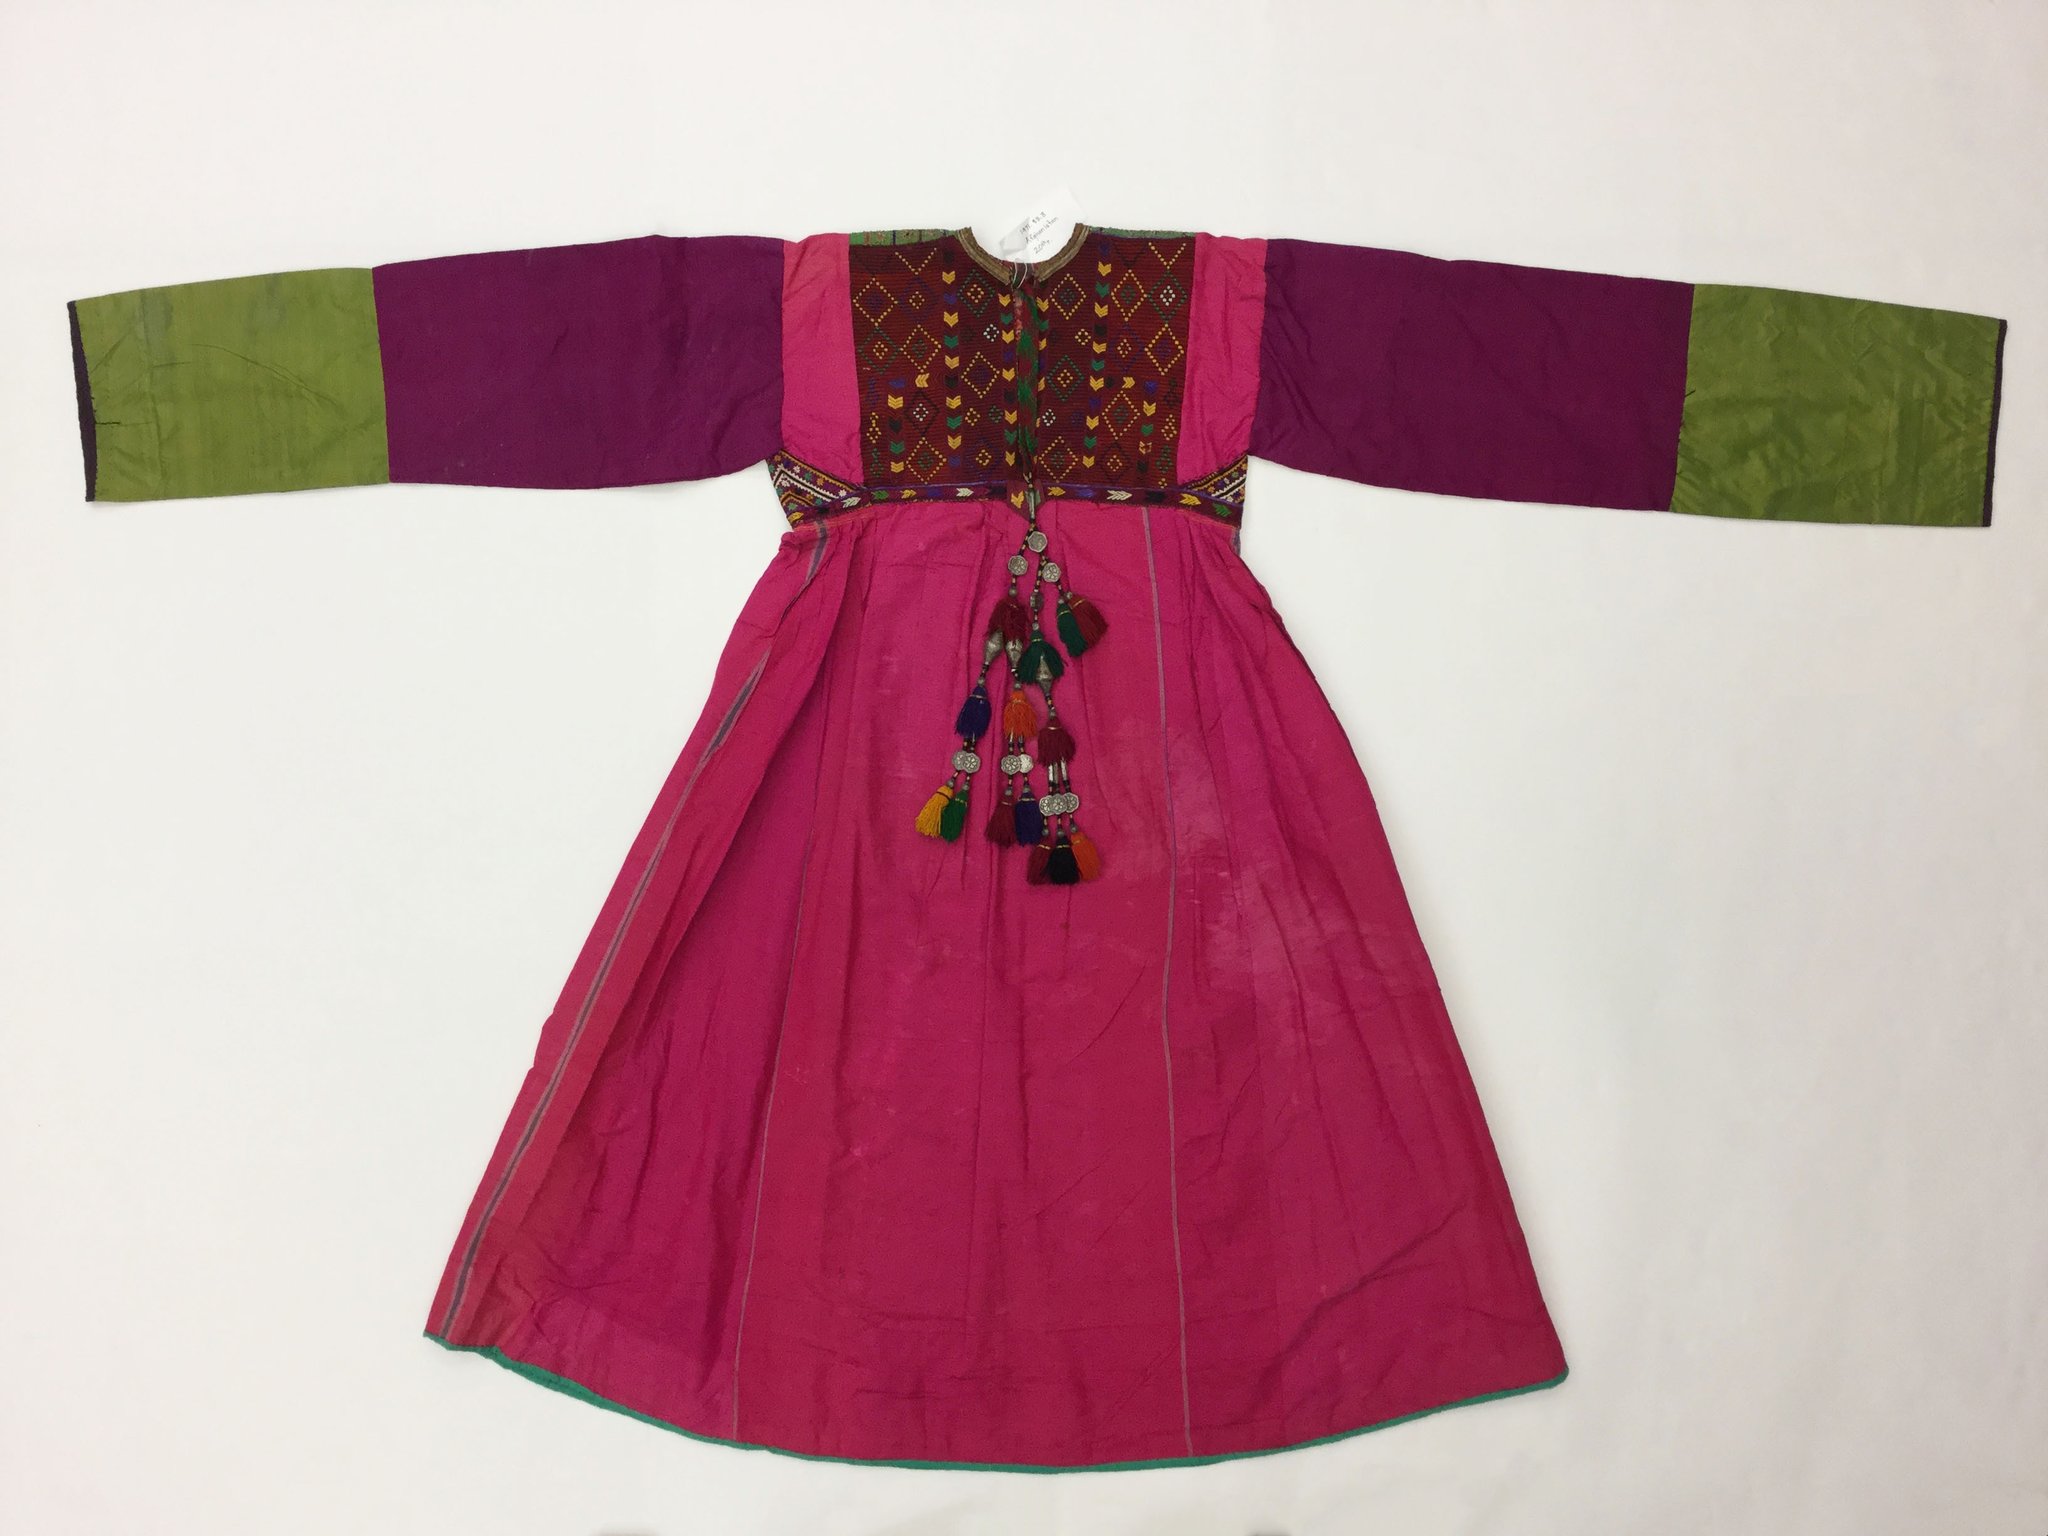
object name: dress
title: Festive Dress of a Hazara Woman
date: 1934-1966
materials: cotton, metal thread, silk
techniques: embroidery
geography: afghanistan